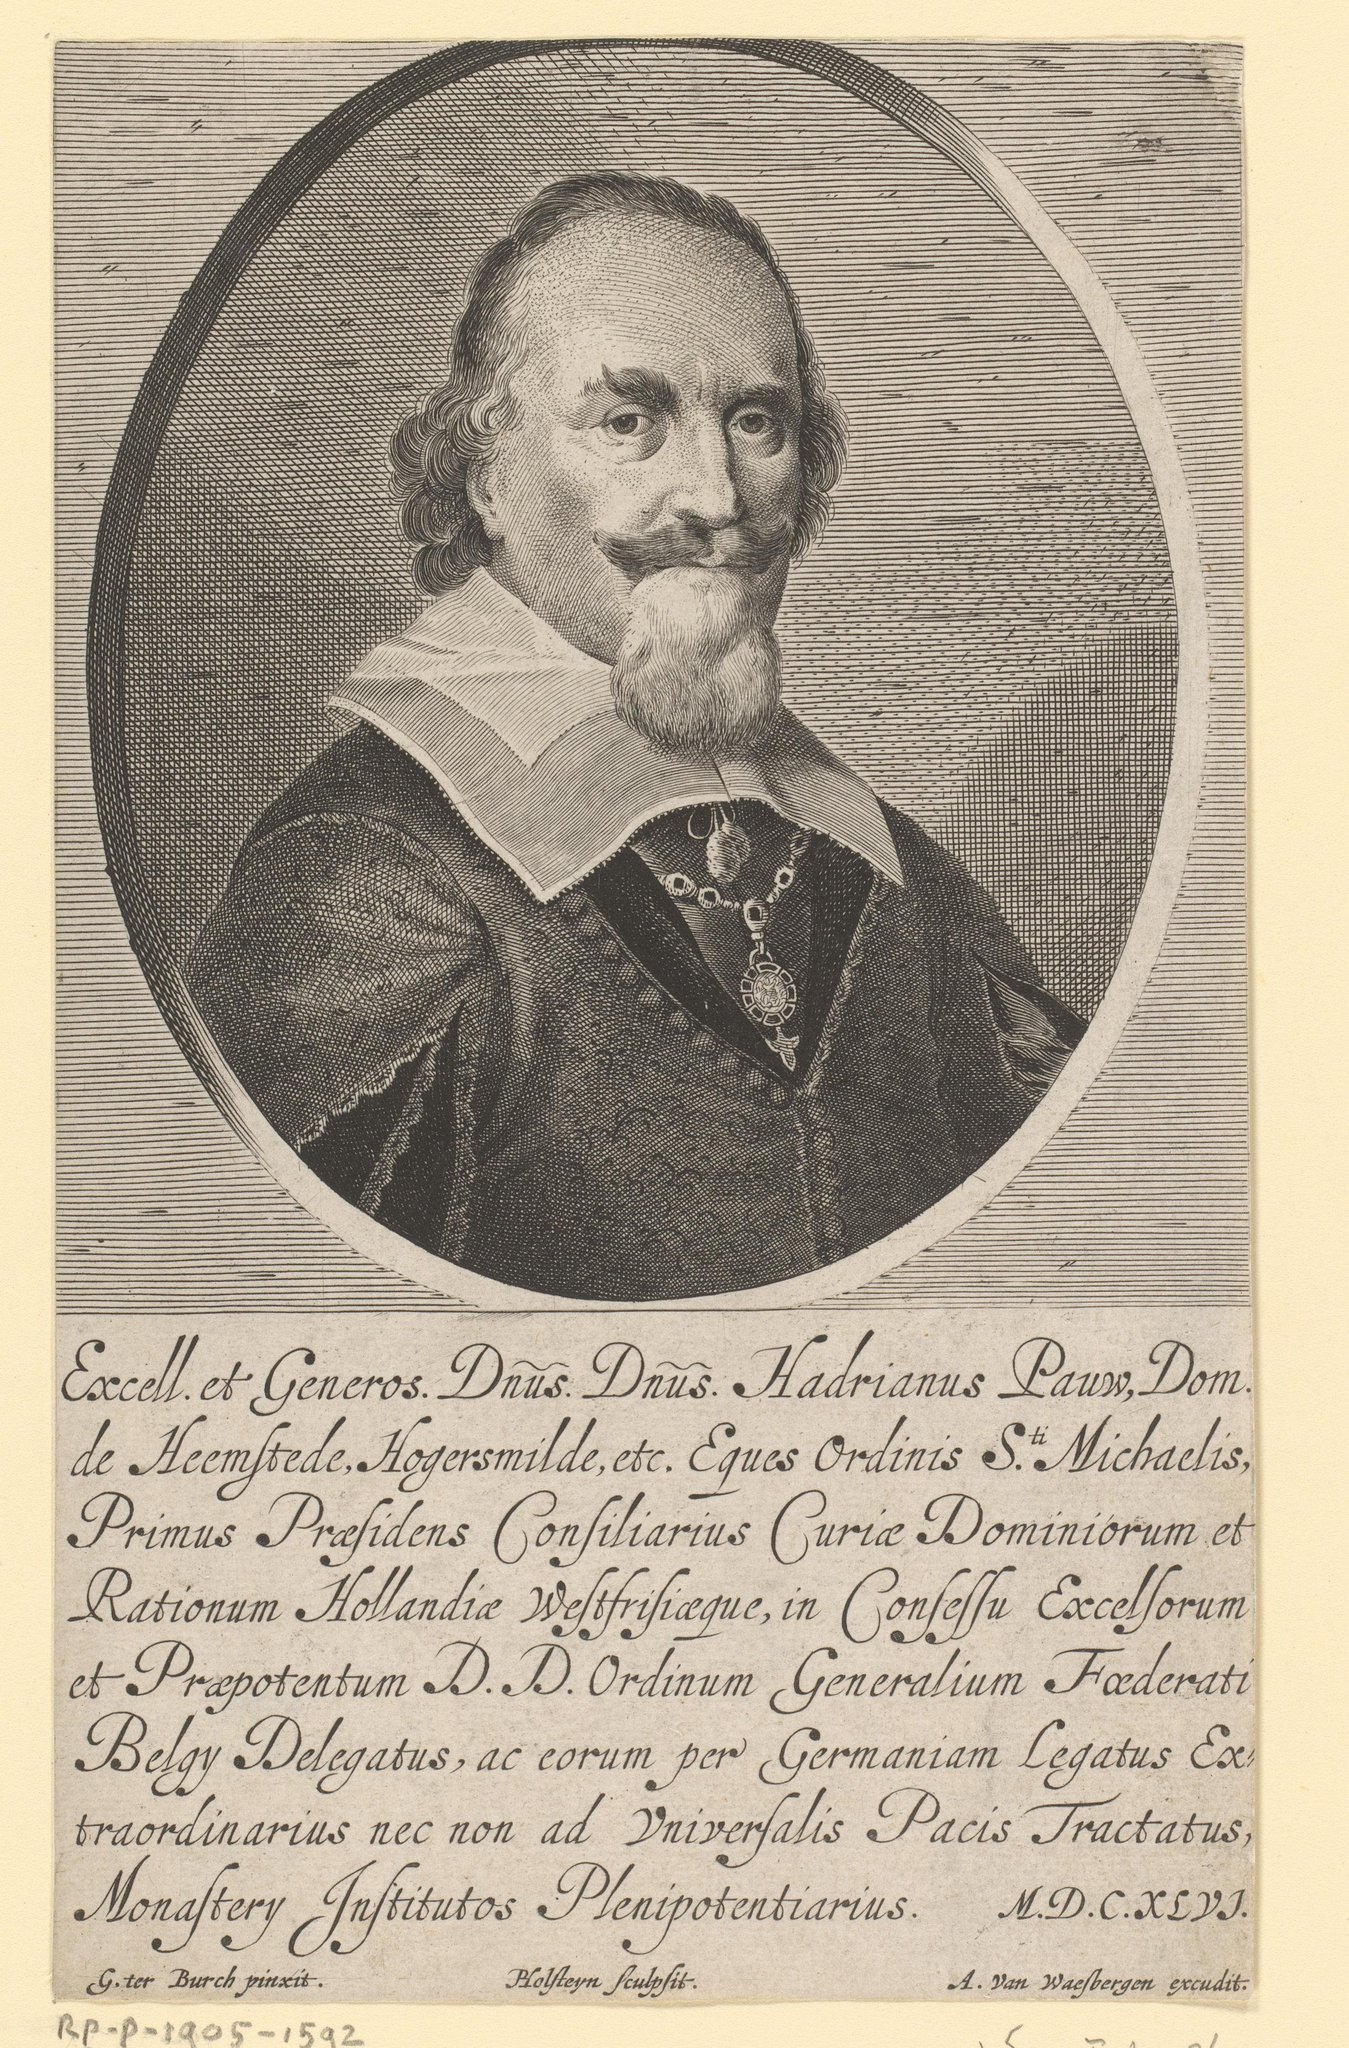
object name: print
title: Icones legatorum Monasterii et Osnabrugae existentium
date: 1644-1646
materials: paper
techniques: engraving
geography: amsterdam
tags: amsterdam, the hague, politician, adriaen pauw (1585-1653), official; civil servant; functionary (in general), historical persons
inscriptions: collector's mark: Lugt 2228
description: Prent maakt deel uit van een serie van 43 prenten. Latere staat van prent gebruikt in de serie 'Pacificatores orbis Christiani in Westphaliam missi anno 1641', uitgegeven door Rombout van den Hoeye in Amsterdam.